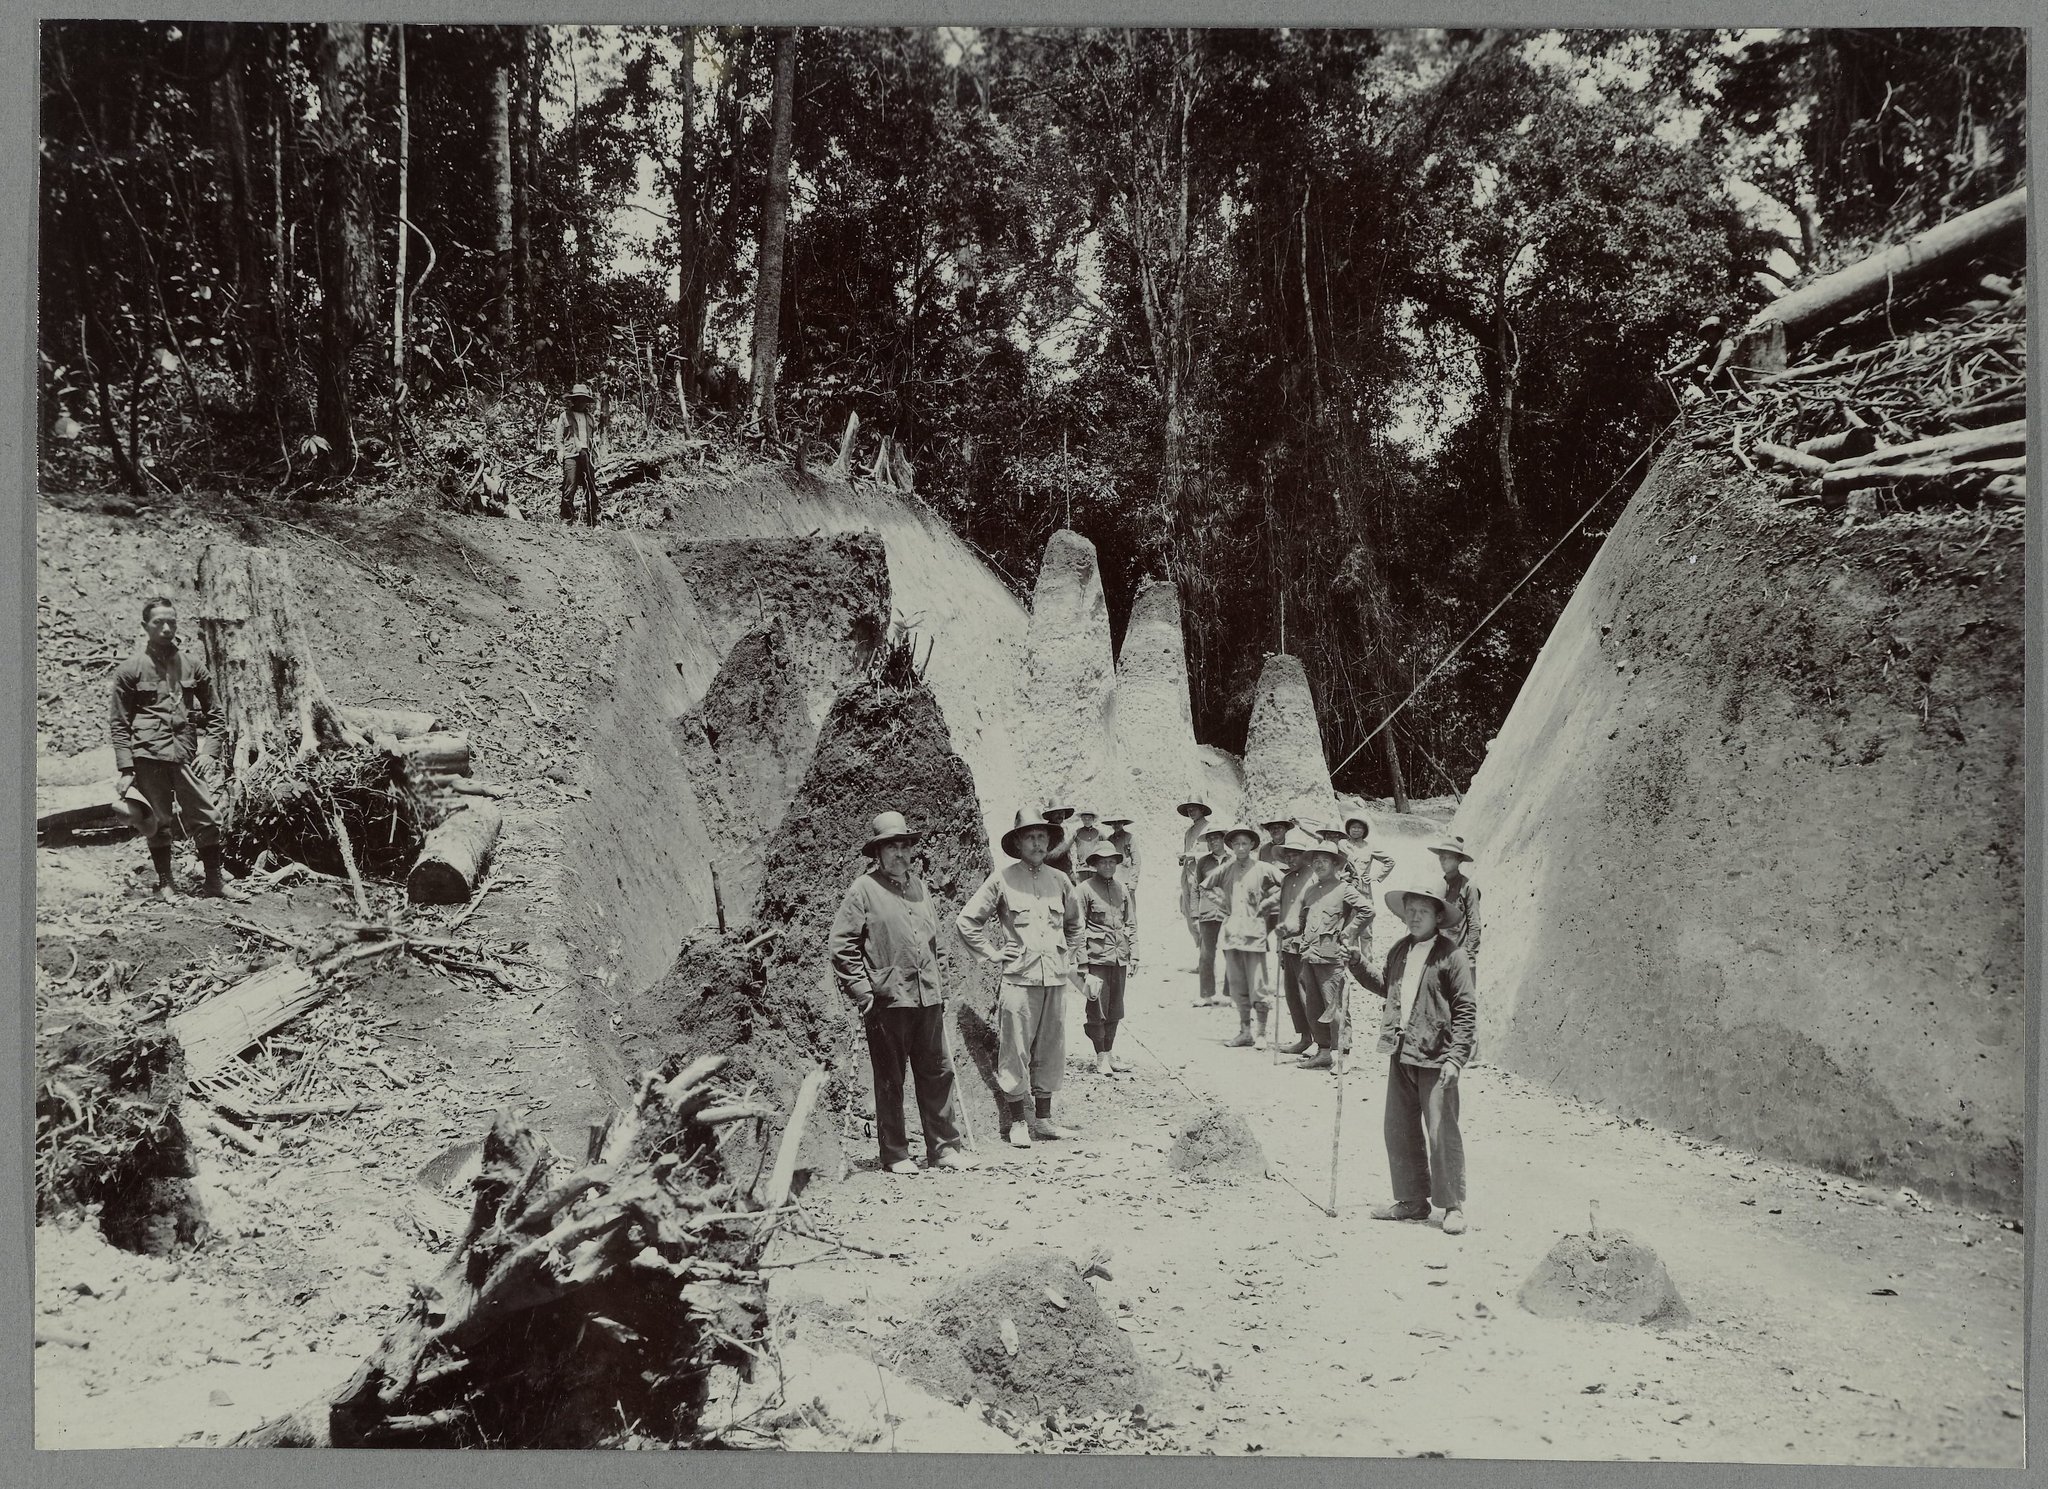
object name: photograph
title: Wegwerkzaamheden met versteningen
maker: Anonymous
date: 1903-1913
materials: photographic support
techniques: photography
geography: north sumatra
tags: arnhem, the hague, albertus dominicus laman trip, landscapes in tropical and sub-tropical regions, road, path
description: Na de expedities naar de Gajo- en Alaslanden o.l.v. Van Daalen (eerste tocht in 1901), werd hij in 1903 belast met voorbereiding van permanente vestiging van Nederlands gezag. Aanleg van een weg van de Noordkust naar het binnenland was hierbij van groot belang. Deze zgn. Gajoweg werd aangelegd tussen 1903 en 1914, van Bireuen aan de kust naar Takinguen aan het bergmeer Danau Lauttawar, totale lente 104 km.